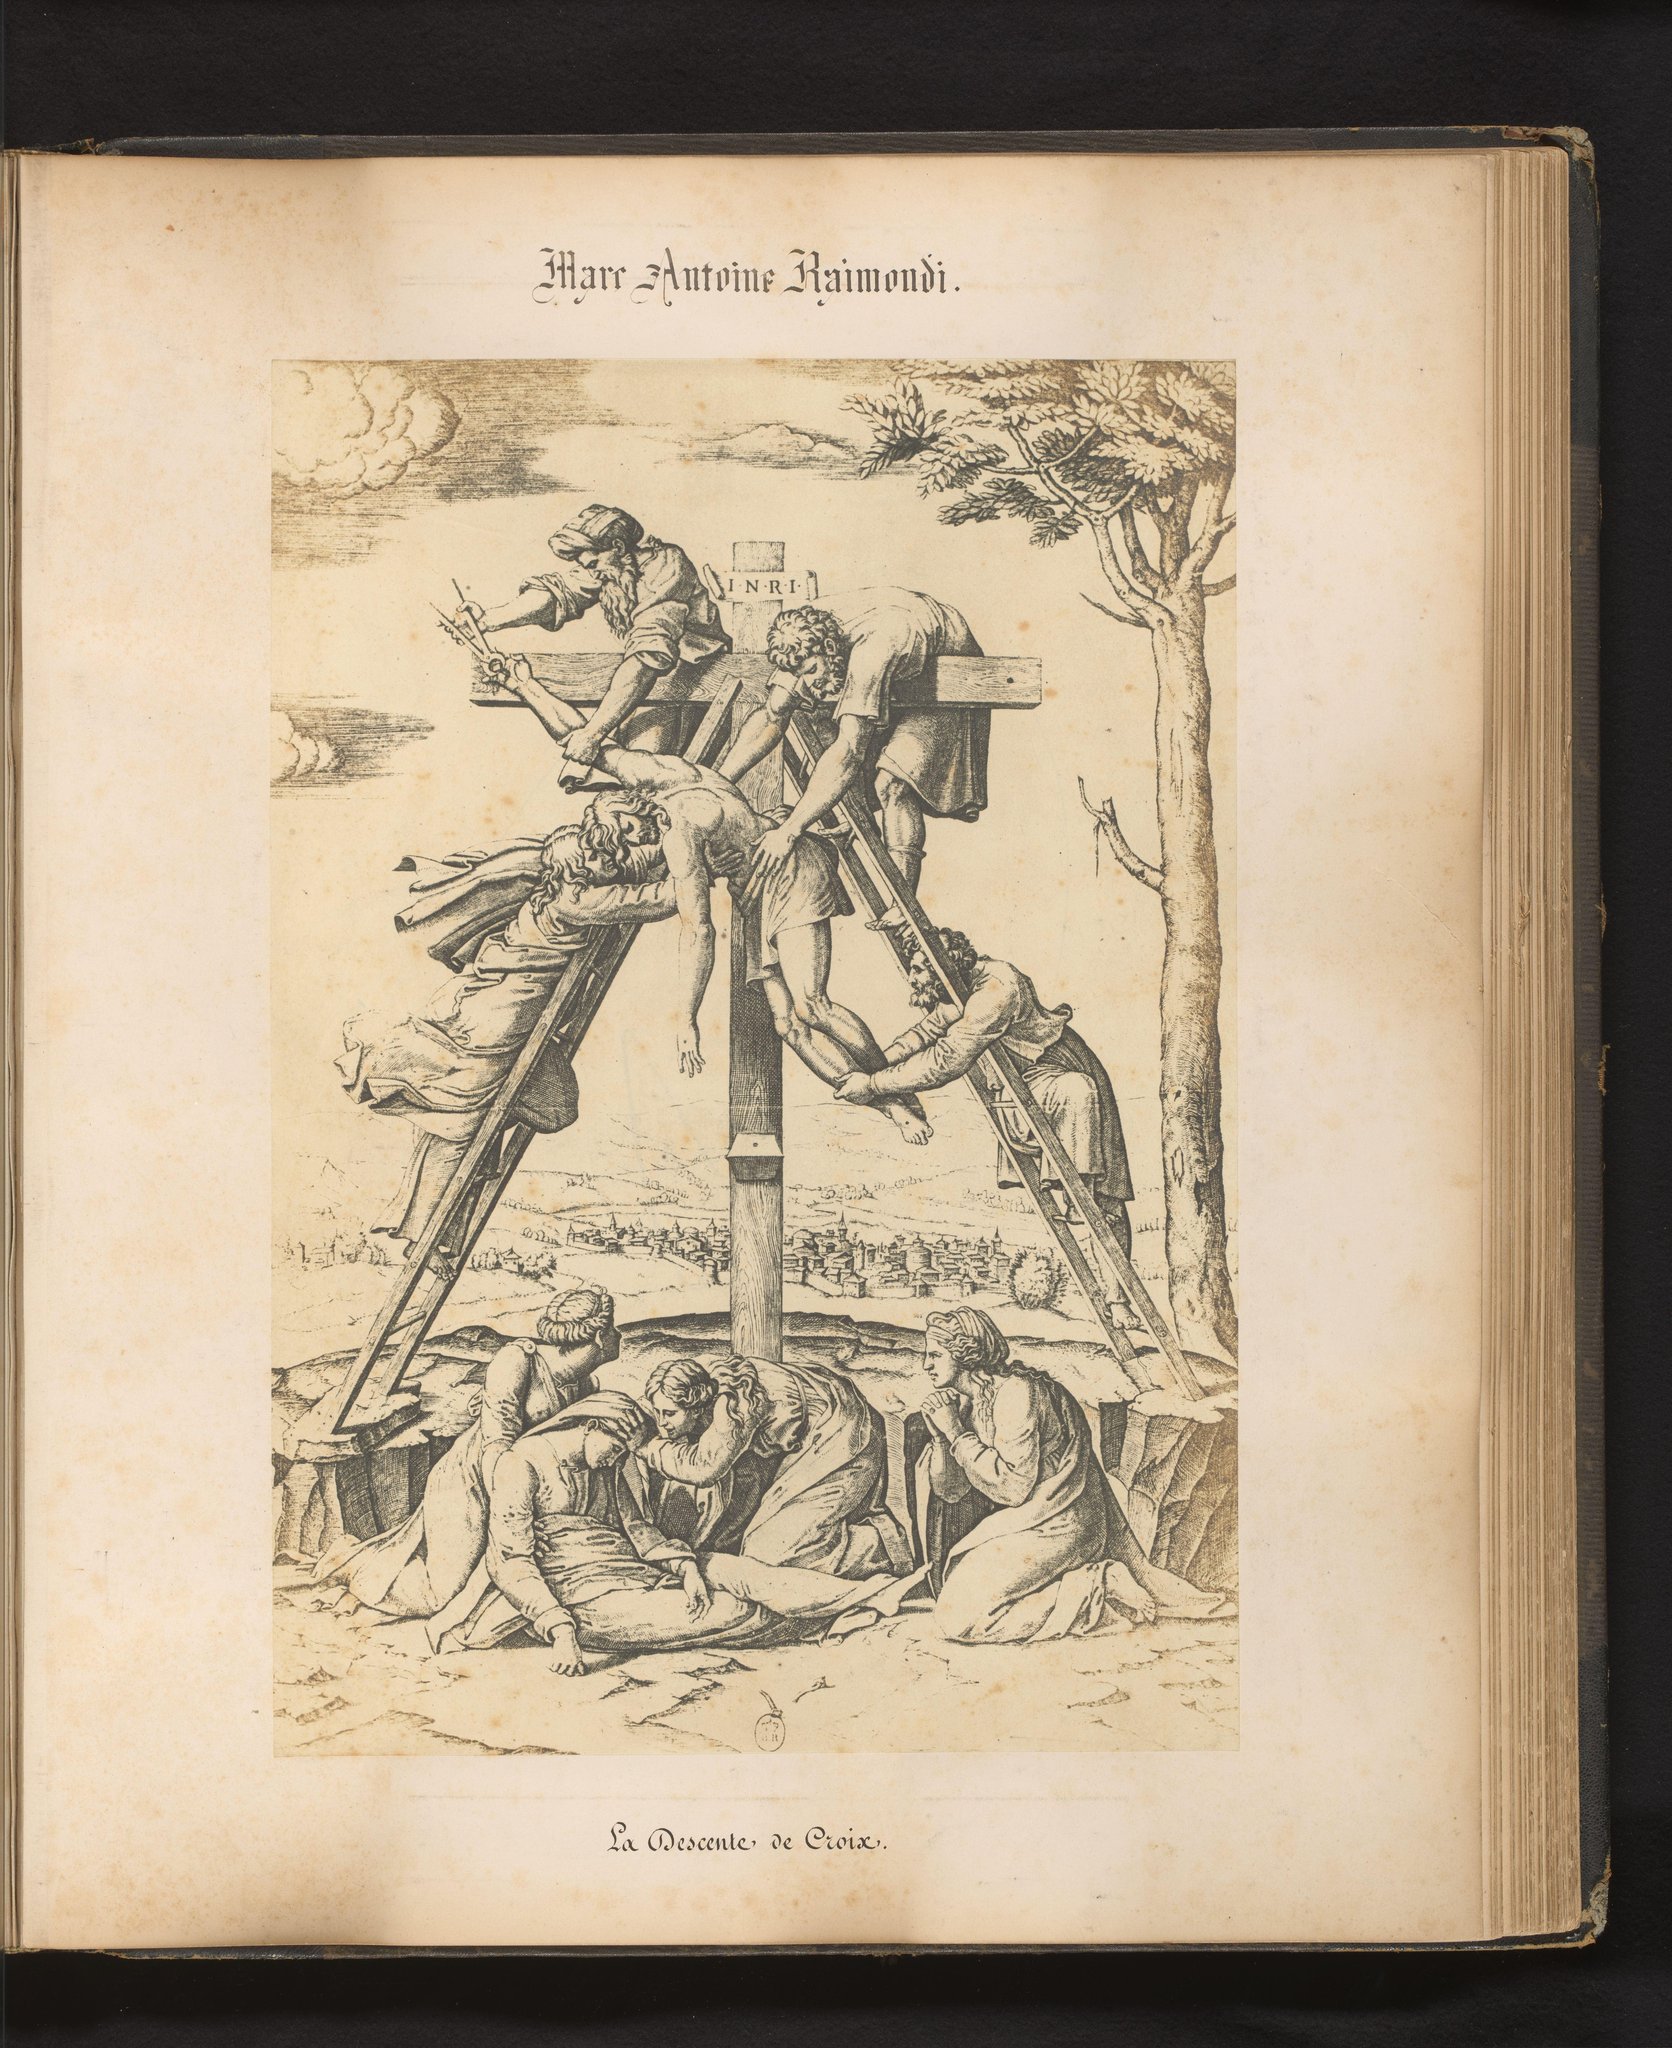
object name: page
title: La Descente de Croix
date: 1848-1853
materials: photographic support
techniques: salted paper print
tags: christ is taken down from the cross (one arm of christ still nailed to the cross)